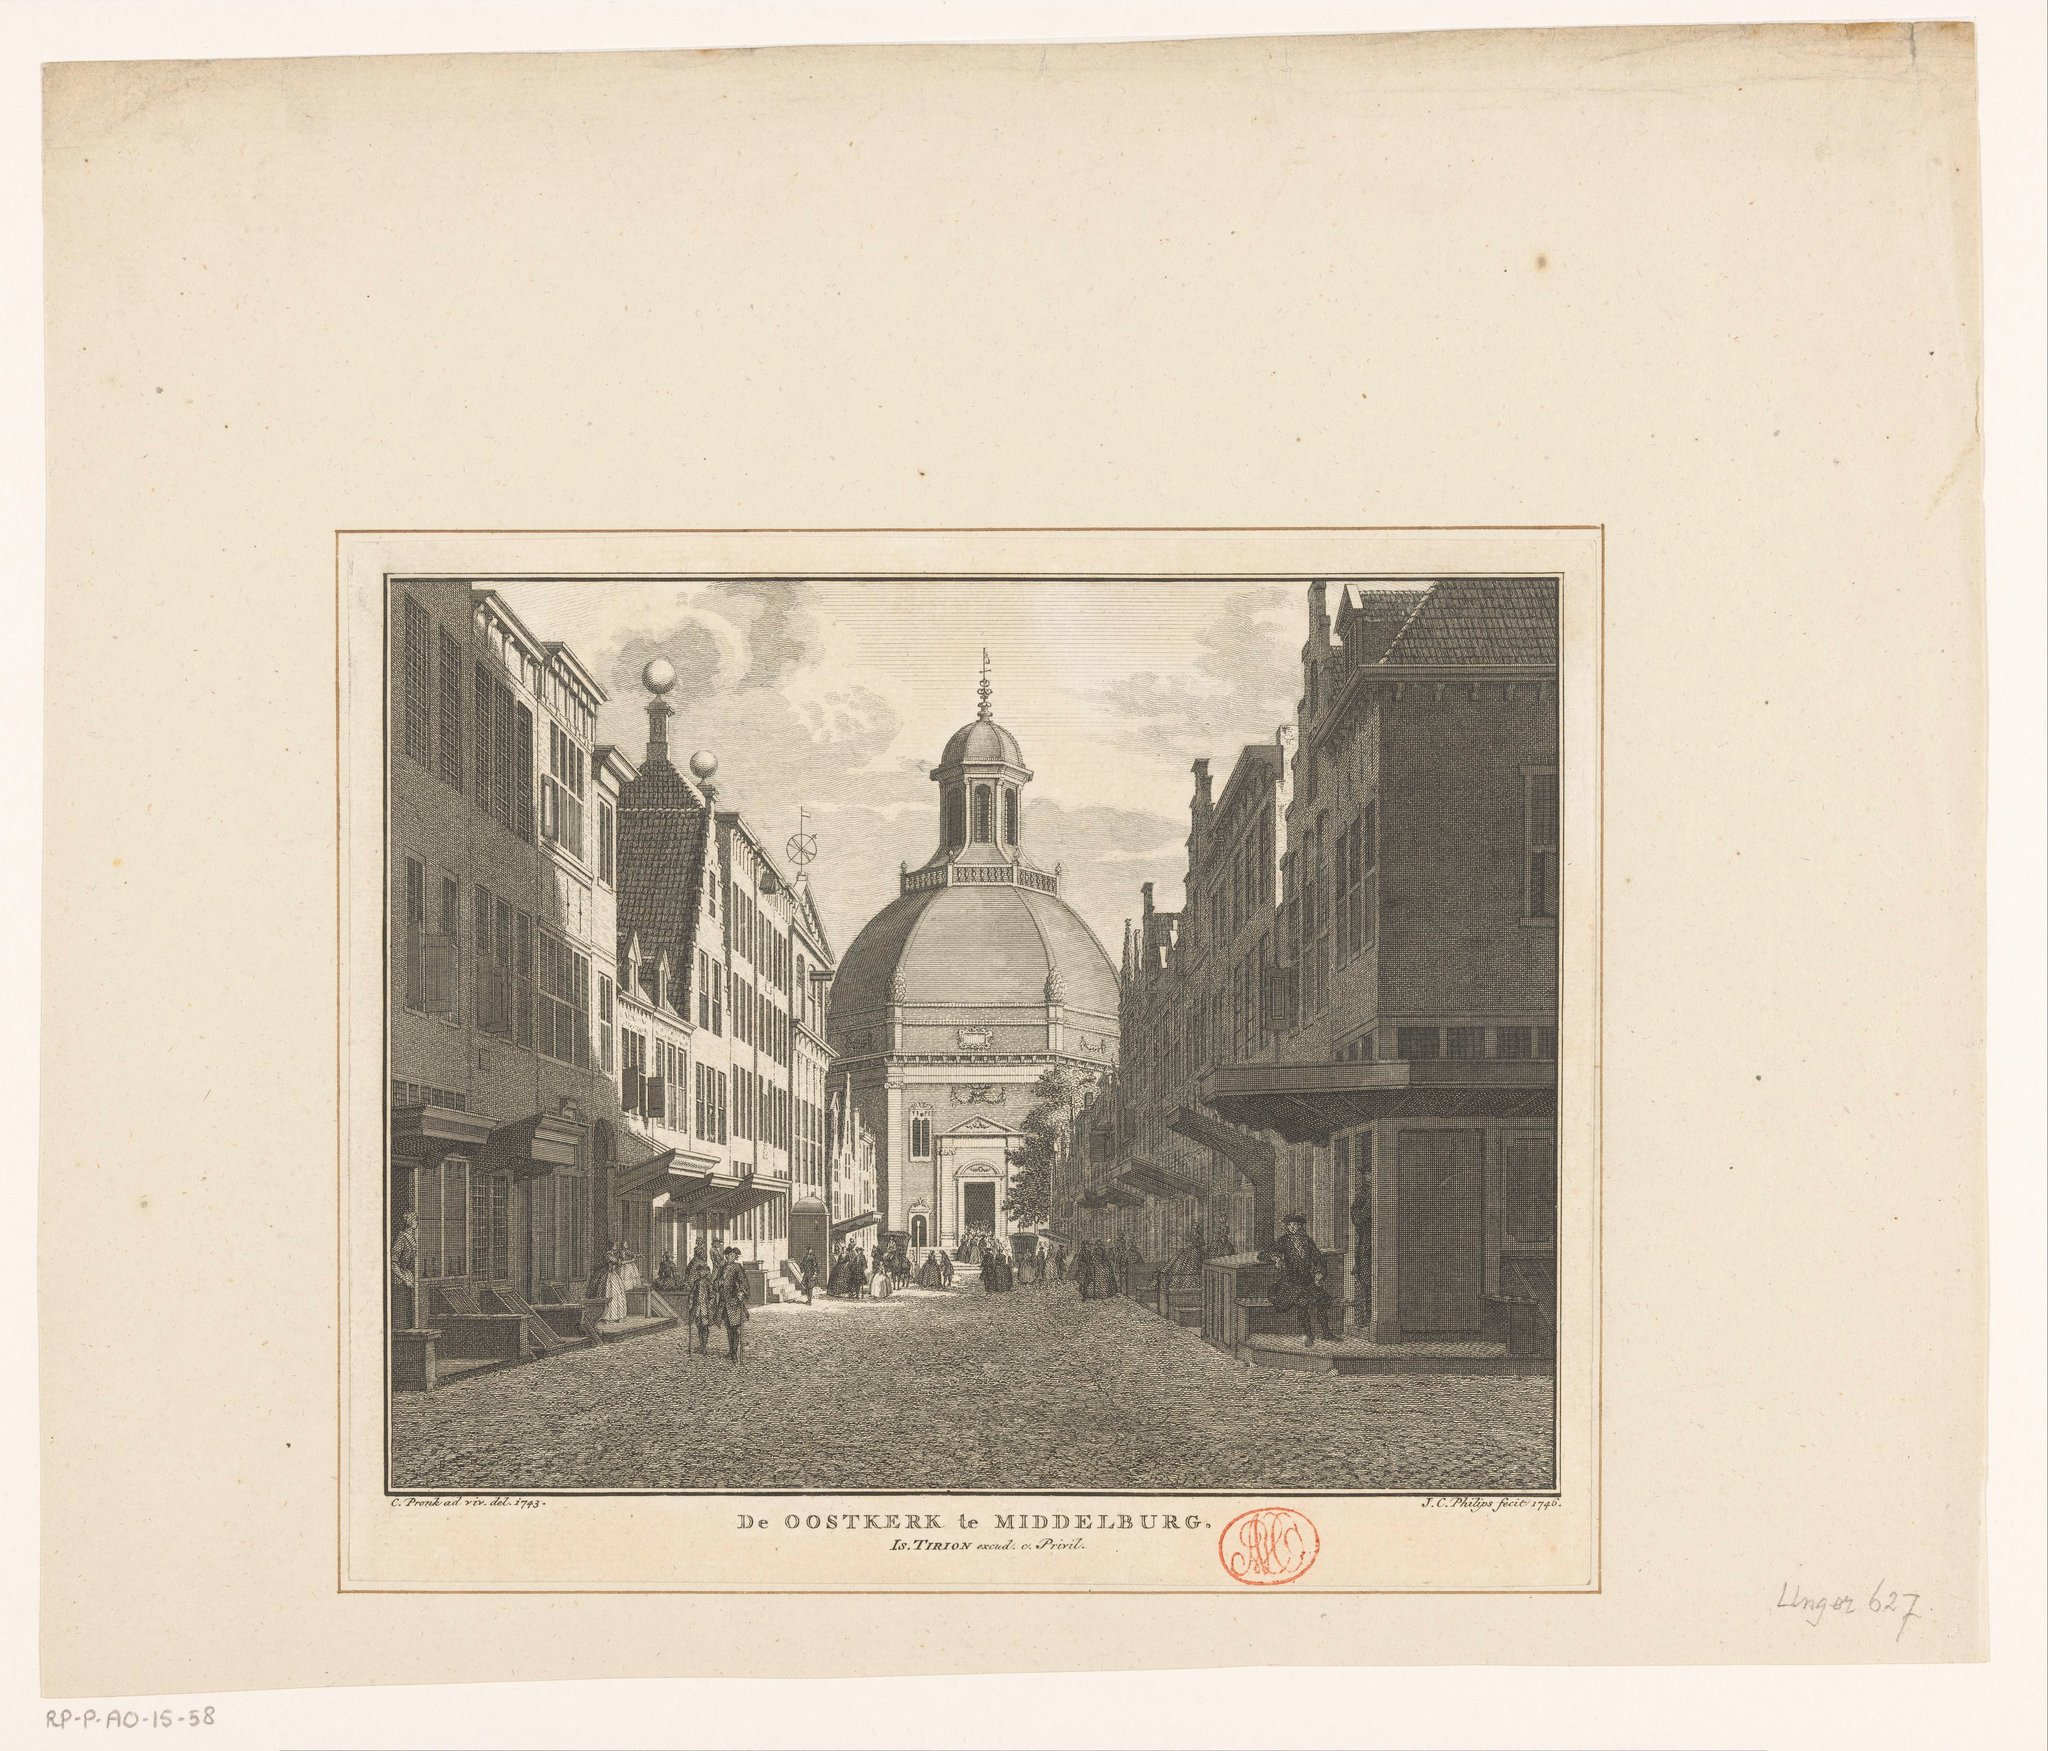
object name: book illustration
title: Gezicht op de Oostkerk te Middelburg, 1743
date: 1746-1760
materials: paper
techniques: etching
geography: amsterdam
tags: church (exterior)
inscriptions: collector's mark: Lugt 195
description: Gezicht op de Oostkerk te Middelburg, in de situatie omstreeks 1743.